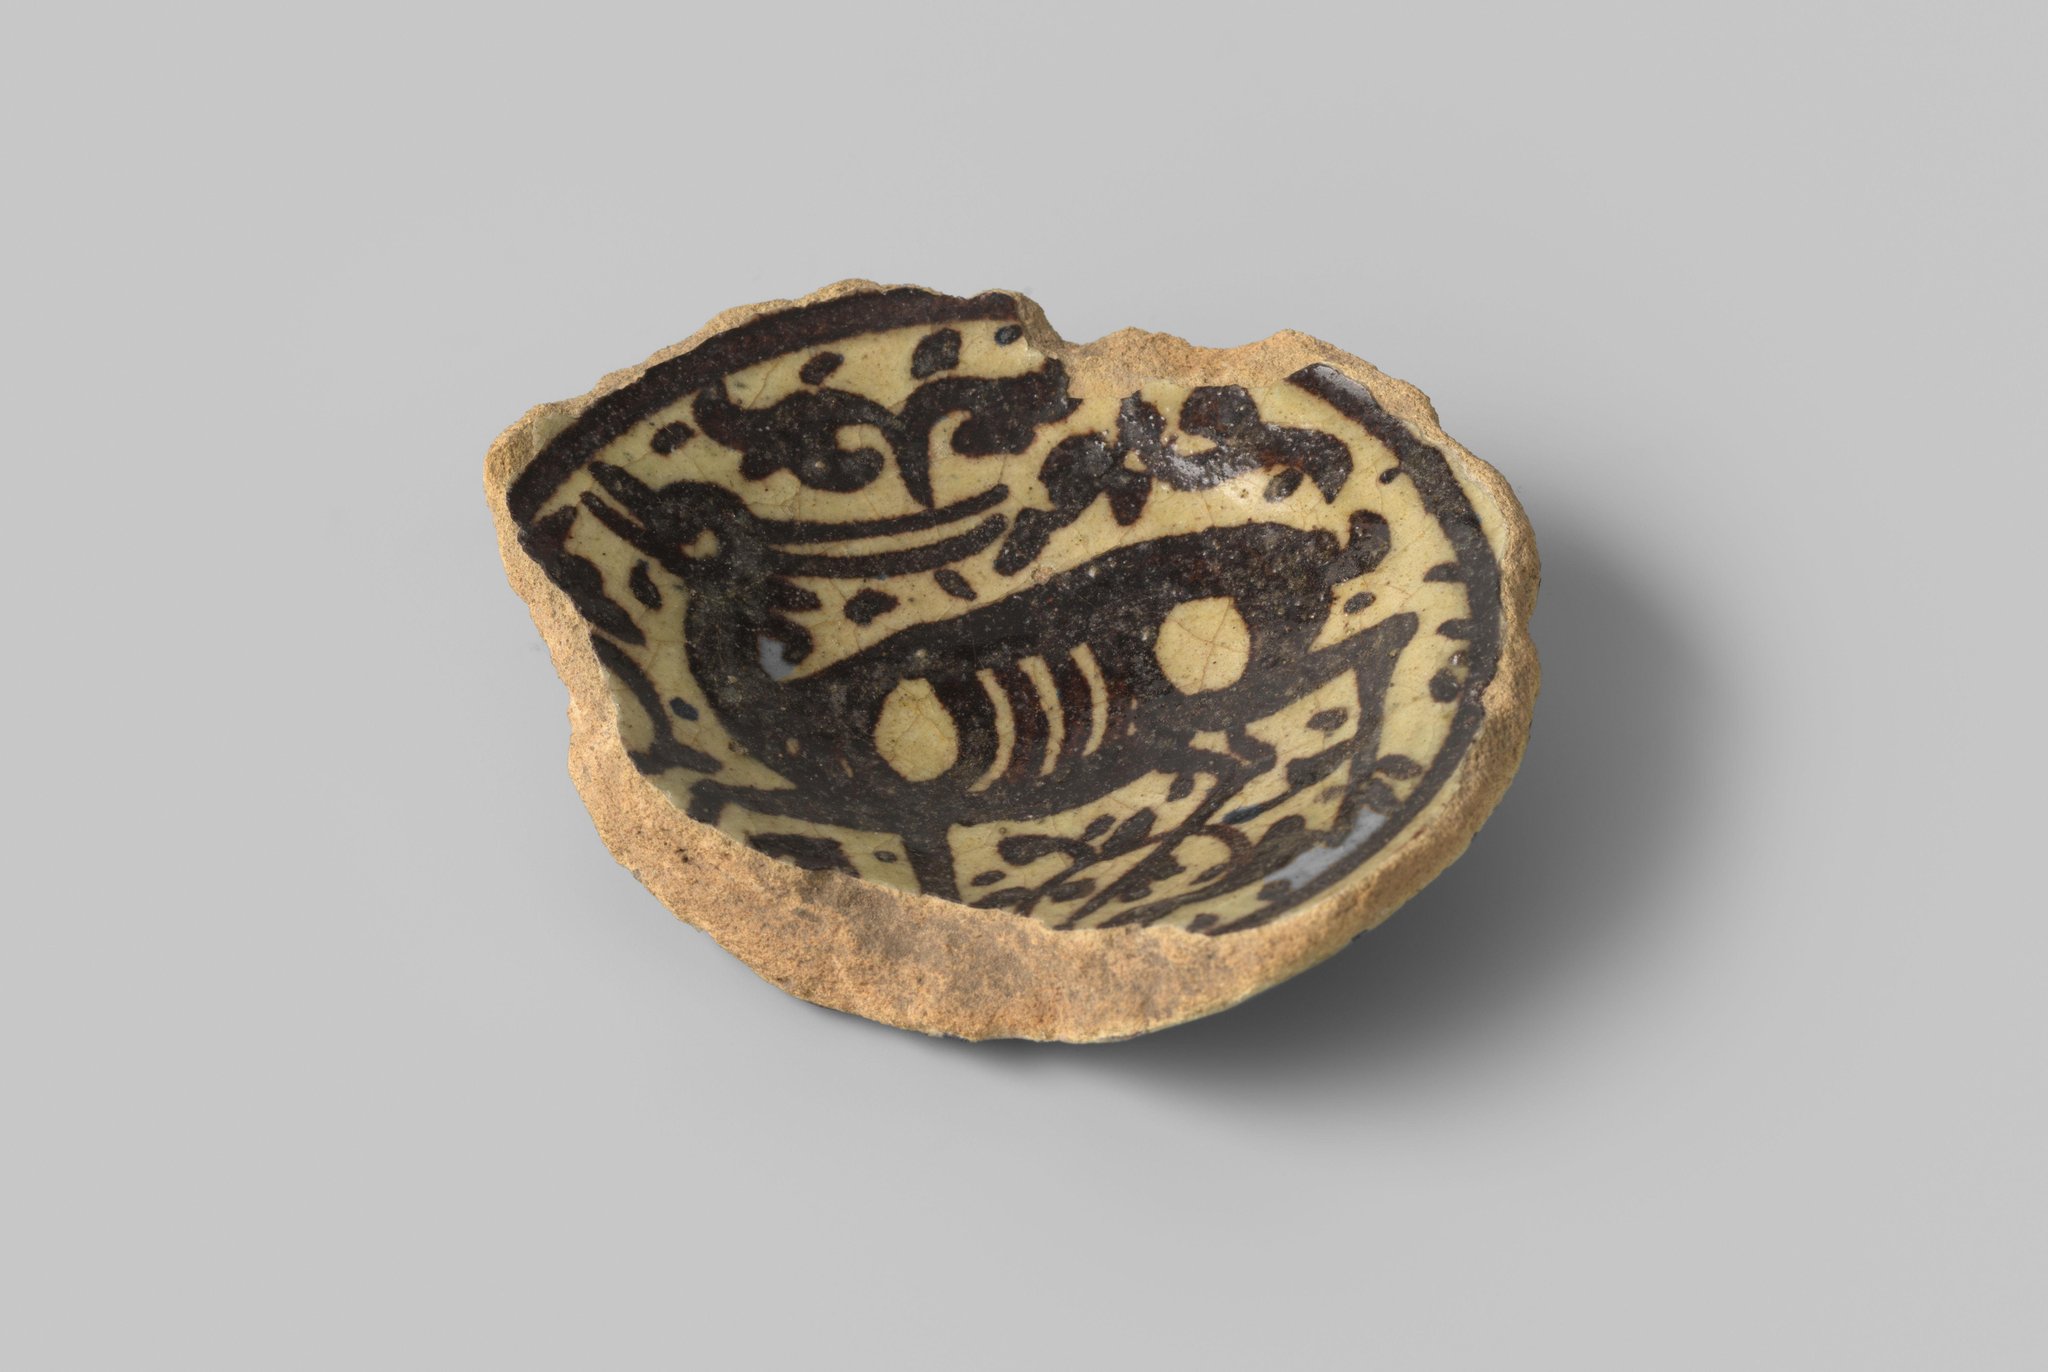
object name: scodello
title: Fragment van een scodello uit de werkplaatsen van Urbino met een figuur in het donkerblauwe midden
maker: Anonymous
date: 1500-1600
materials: earthenware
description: Fragment van een scodello uit de werkplaatsen van Urbino. Op groen blauwe fond een tekening in geelgroen en wit van vruchten en laurierbladeren als rand. In het donkerblauw midden een figuur. Fragment gevonden te Cairo. In twee stukken.